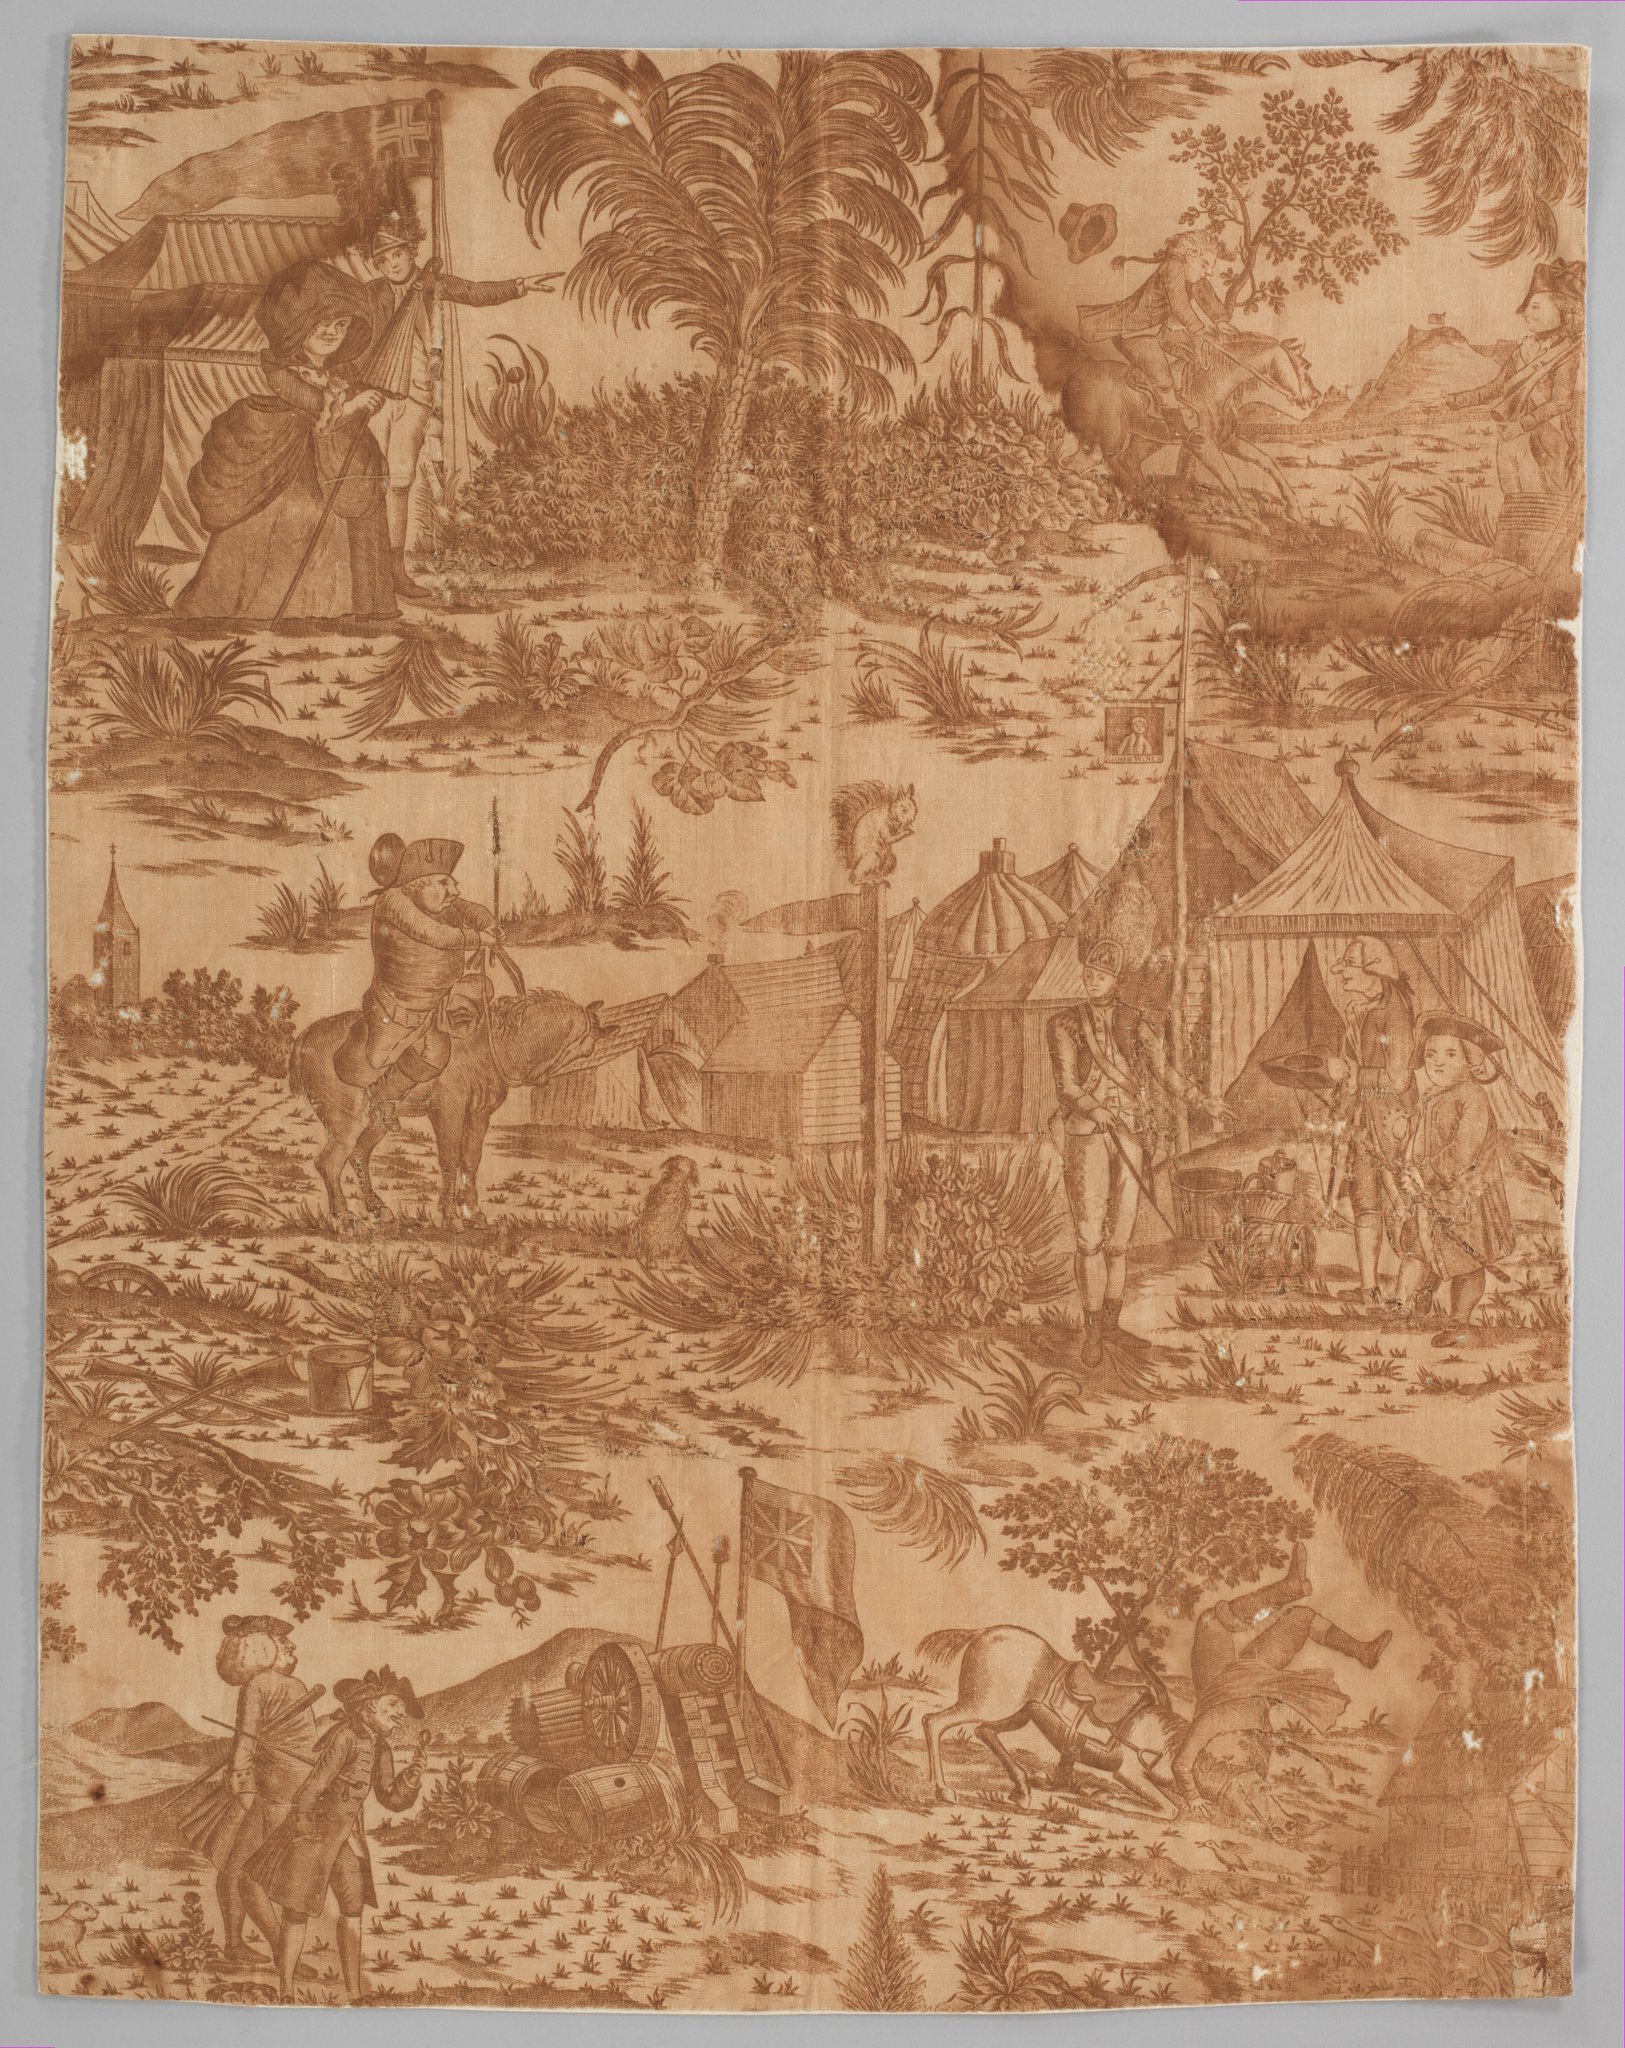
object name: piece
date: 1785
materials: cotton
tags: tents,men,women,horses